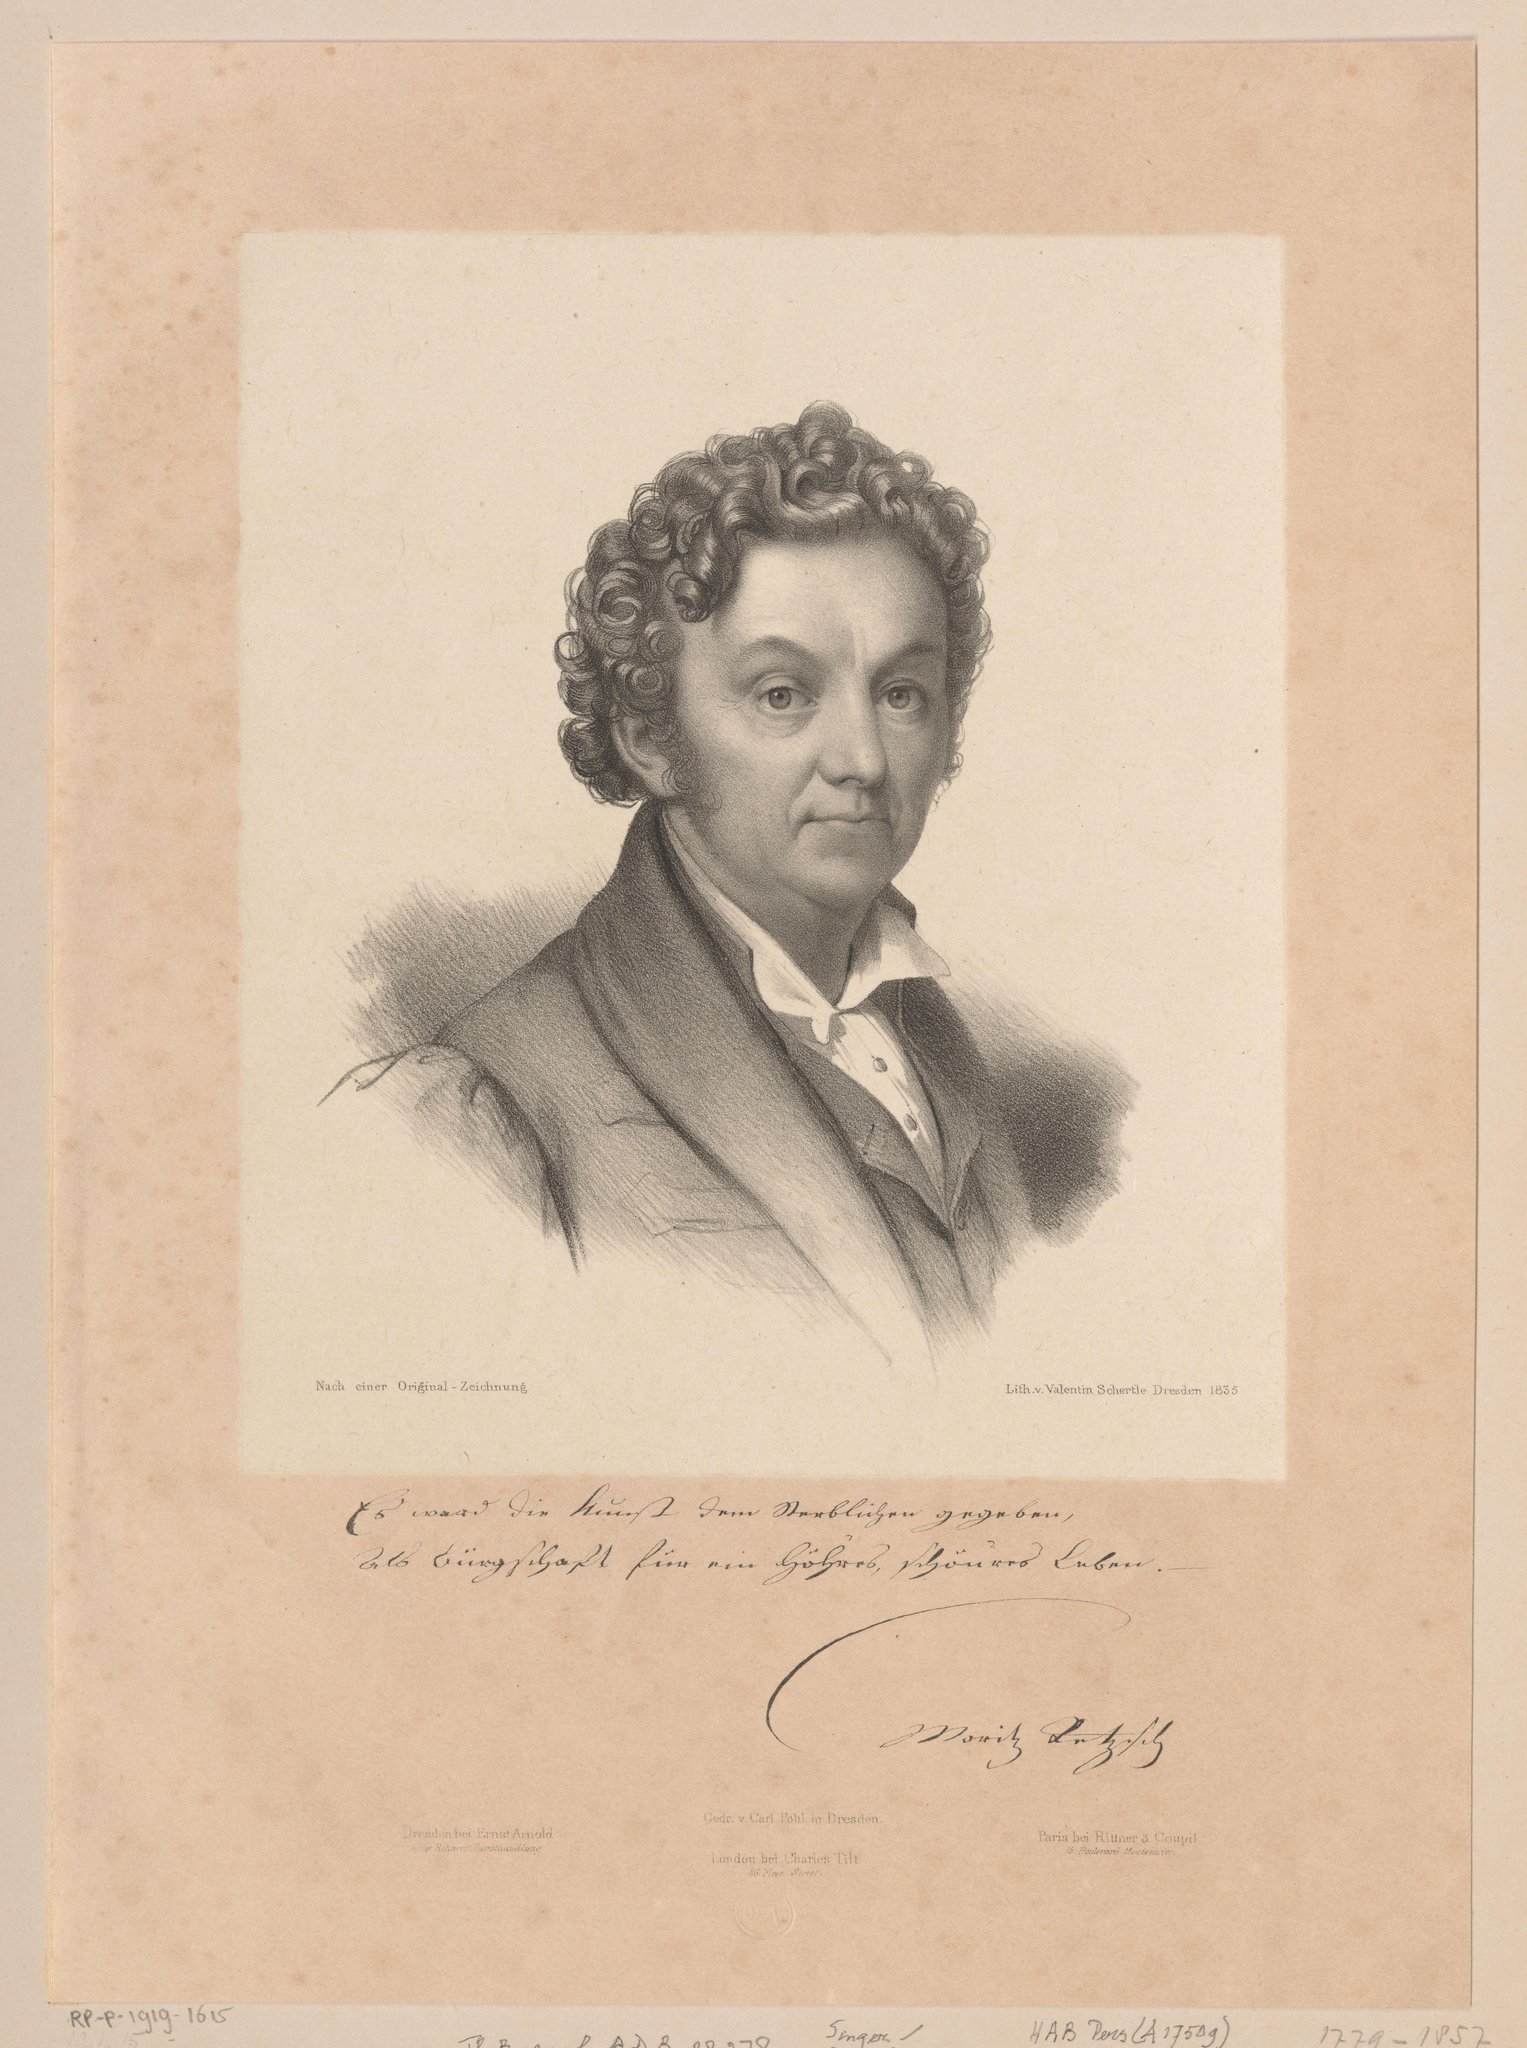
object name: print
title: Portret van Moritz Retzsch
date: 1835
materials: paper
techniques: lithograph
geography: paris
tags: moritz retzsch, historical persons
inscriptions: collector's mark: Lugt 2228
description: Onder het portret een facsimile van de handtekening van de geportretteerde.